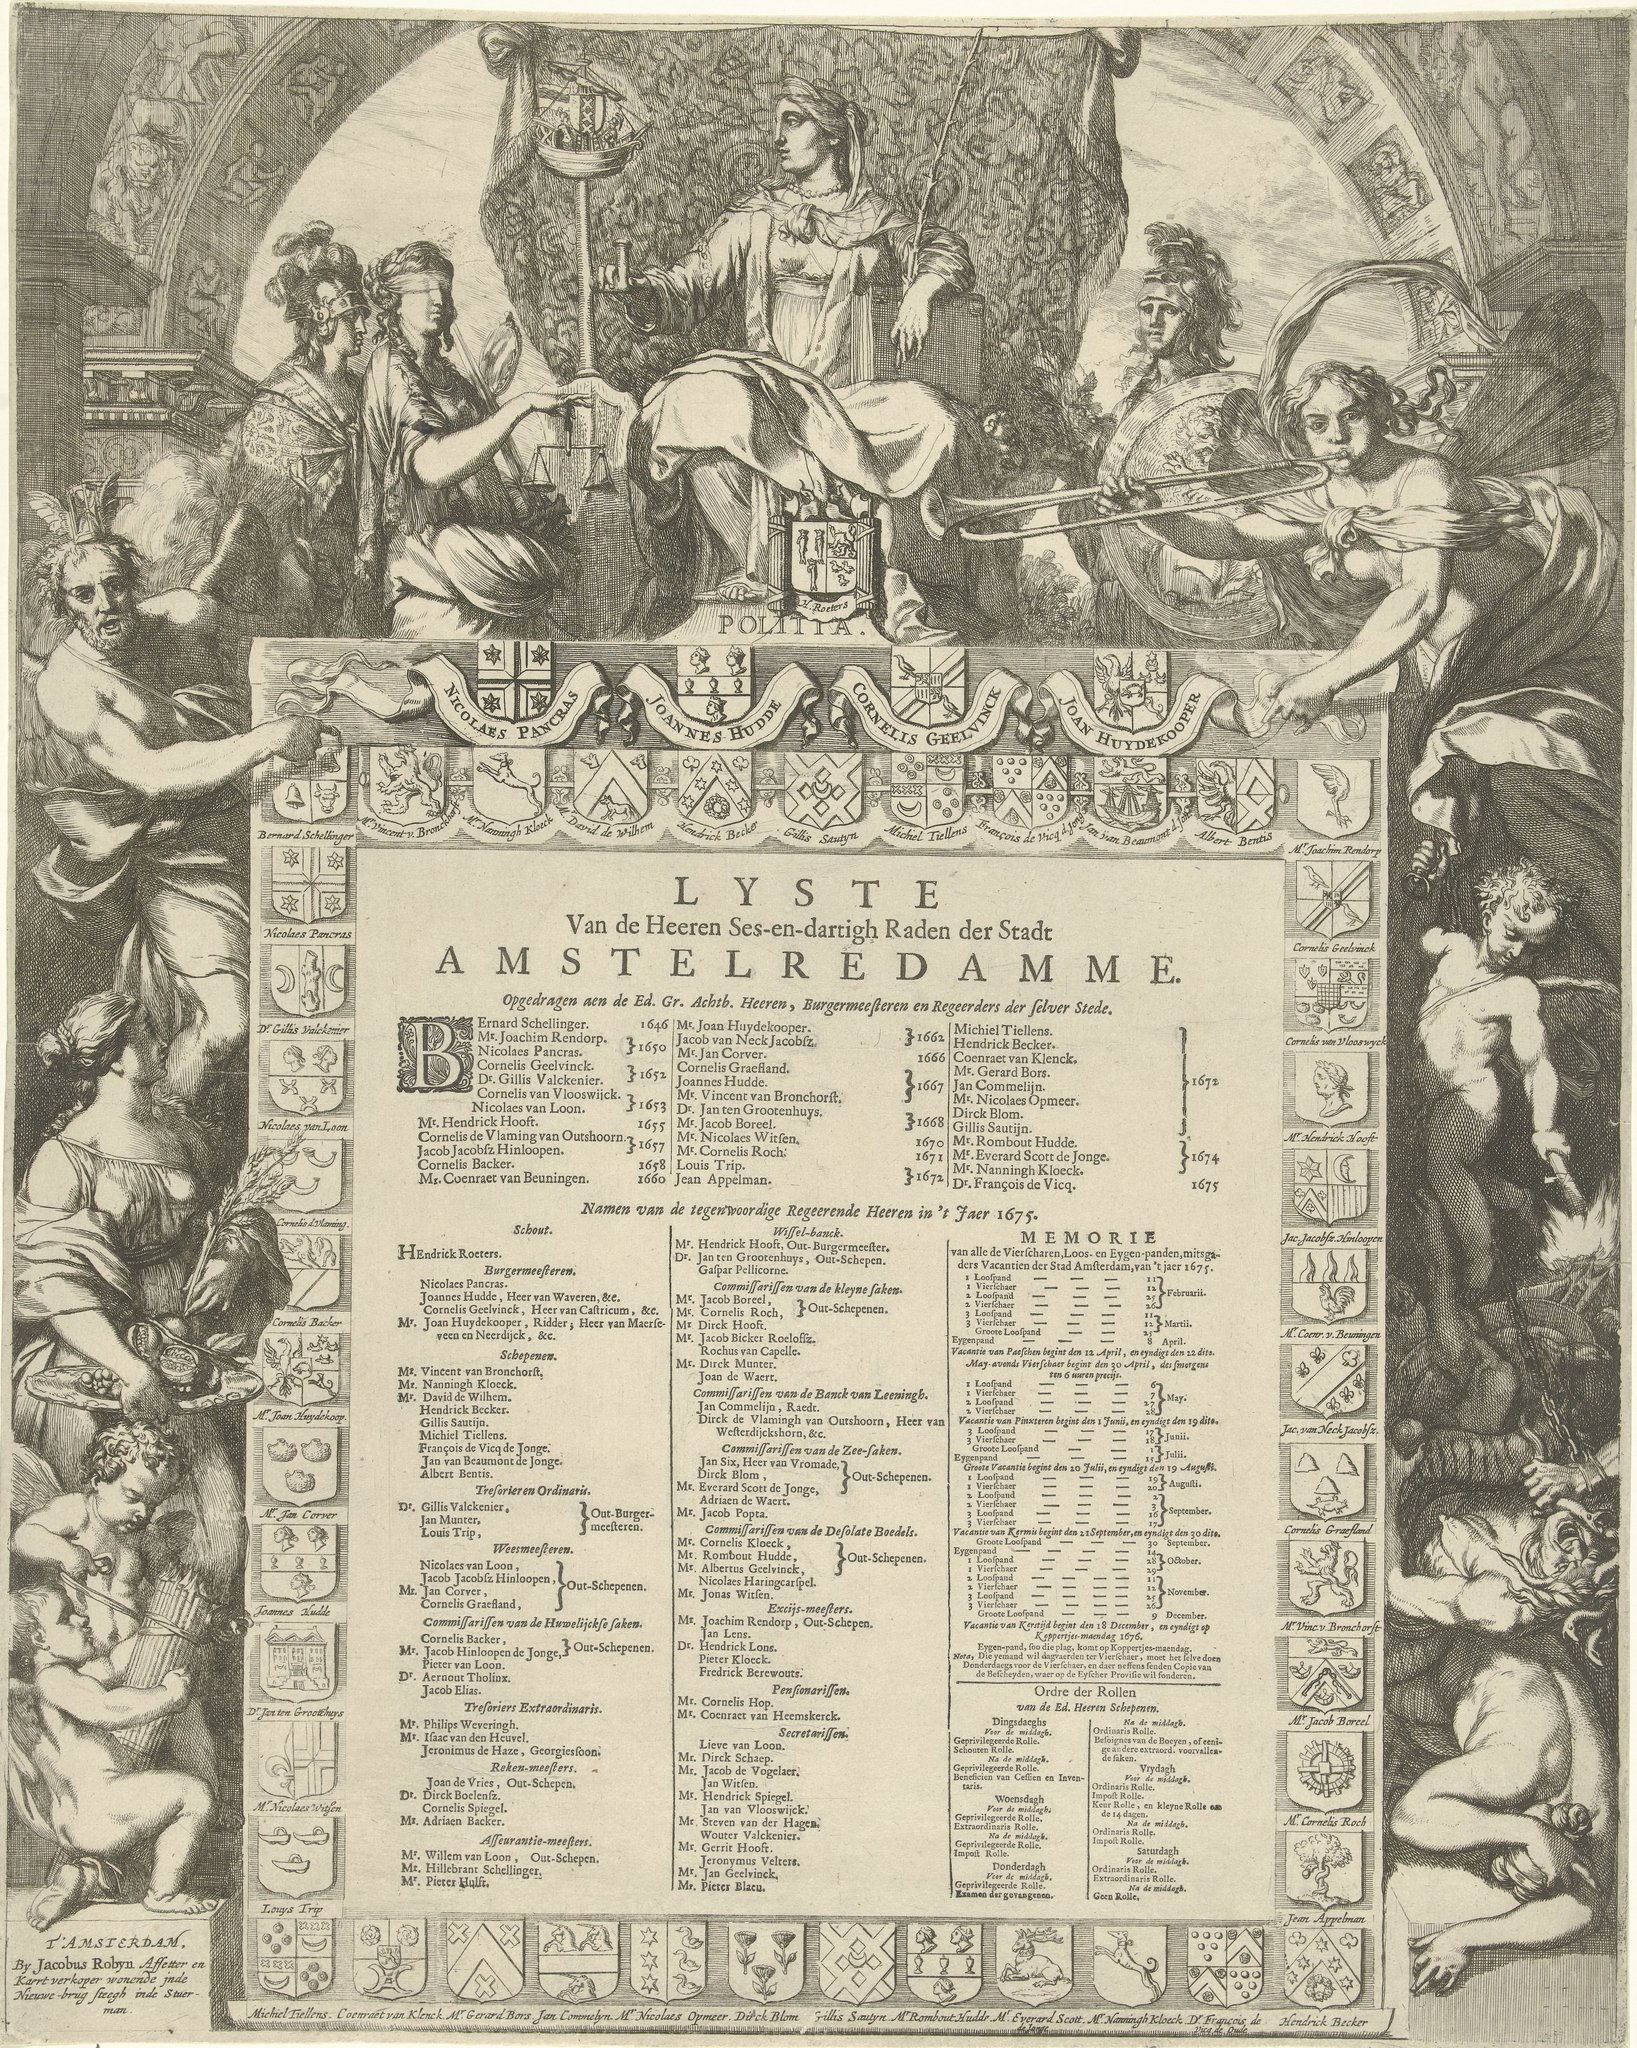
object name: print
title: Allegorie op het bestuur van de stad Amsterdam met de naamlijst en wapens van regeringsleden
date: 1672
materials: paper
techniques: etching, letterpress printing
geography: amsterdam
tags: cities represented allegorically or symbolically, armorial bearing, heraldry, good government, amsterdam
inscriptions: collector's mark: Lugt 2228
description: Een lijst met namen van Amsterdamse regeringsleden, omkaderd door hun familiewapens. Middenboven troont de personificatie van het bestuur van Amsterdam (Politia), aan haar voeten staat het wapen van H. Roeters. Politia's hand rust op een met zeilschip versierd roer, onder haar arm draagt ze een boek. Links van Politia wordt de geblinddoekte Rechtvaardigheid (weegschaal) gevolgd door Voorzichtigheid (spiegel). Schuin onder dit tweetal wijst Vader Tijd (gevleugelde zandloper) op de verschillende wapens in de omlijsting. Onder hem staat de gepersonifieerde overvloed met vruchten en koren in haar handen bij twee putti die pijlen samenbundelen, symbool van eenheid. Rechts van Politia staat Minerva die de wijsheid met een olijftak symboliseert, naast haar vliegt de bazuin blazende Faam. Onder de Faam verbrandt een putto met zijn toorts de gepersonifieerde oorlog en ligt de kermende Tweedracht vastgeketend.